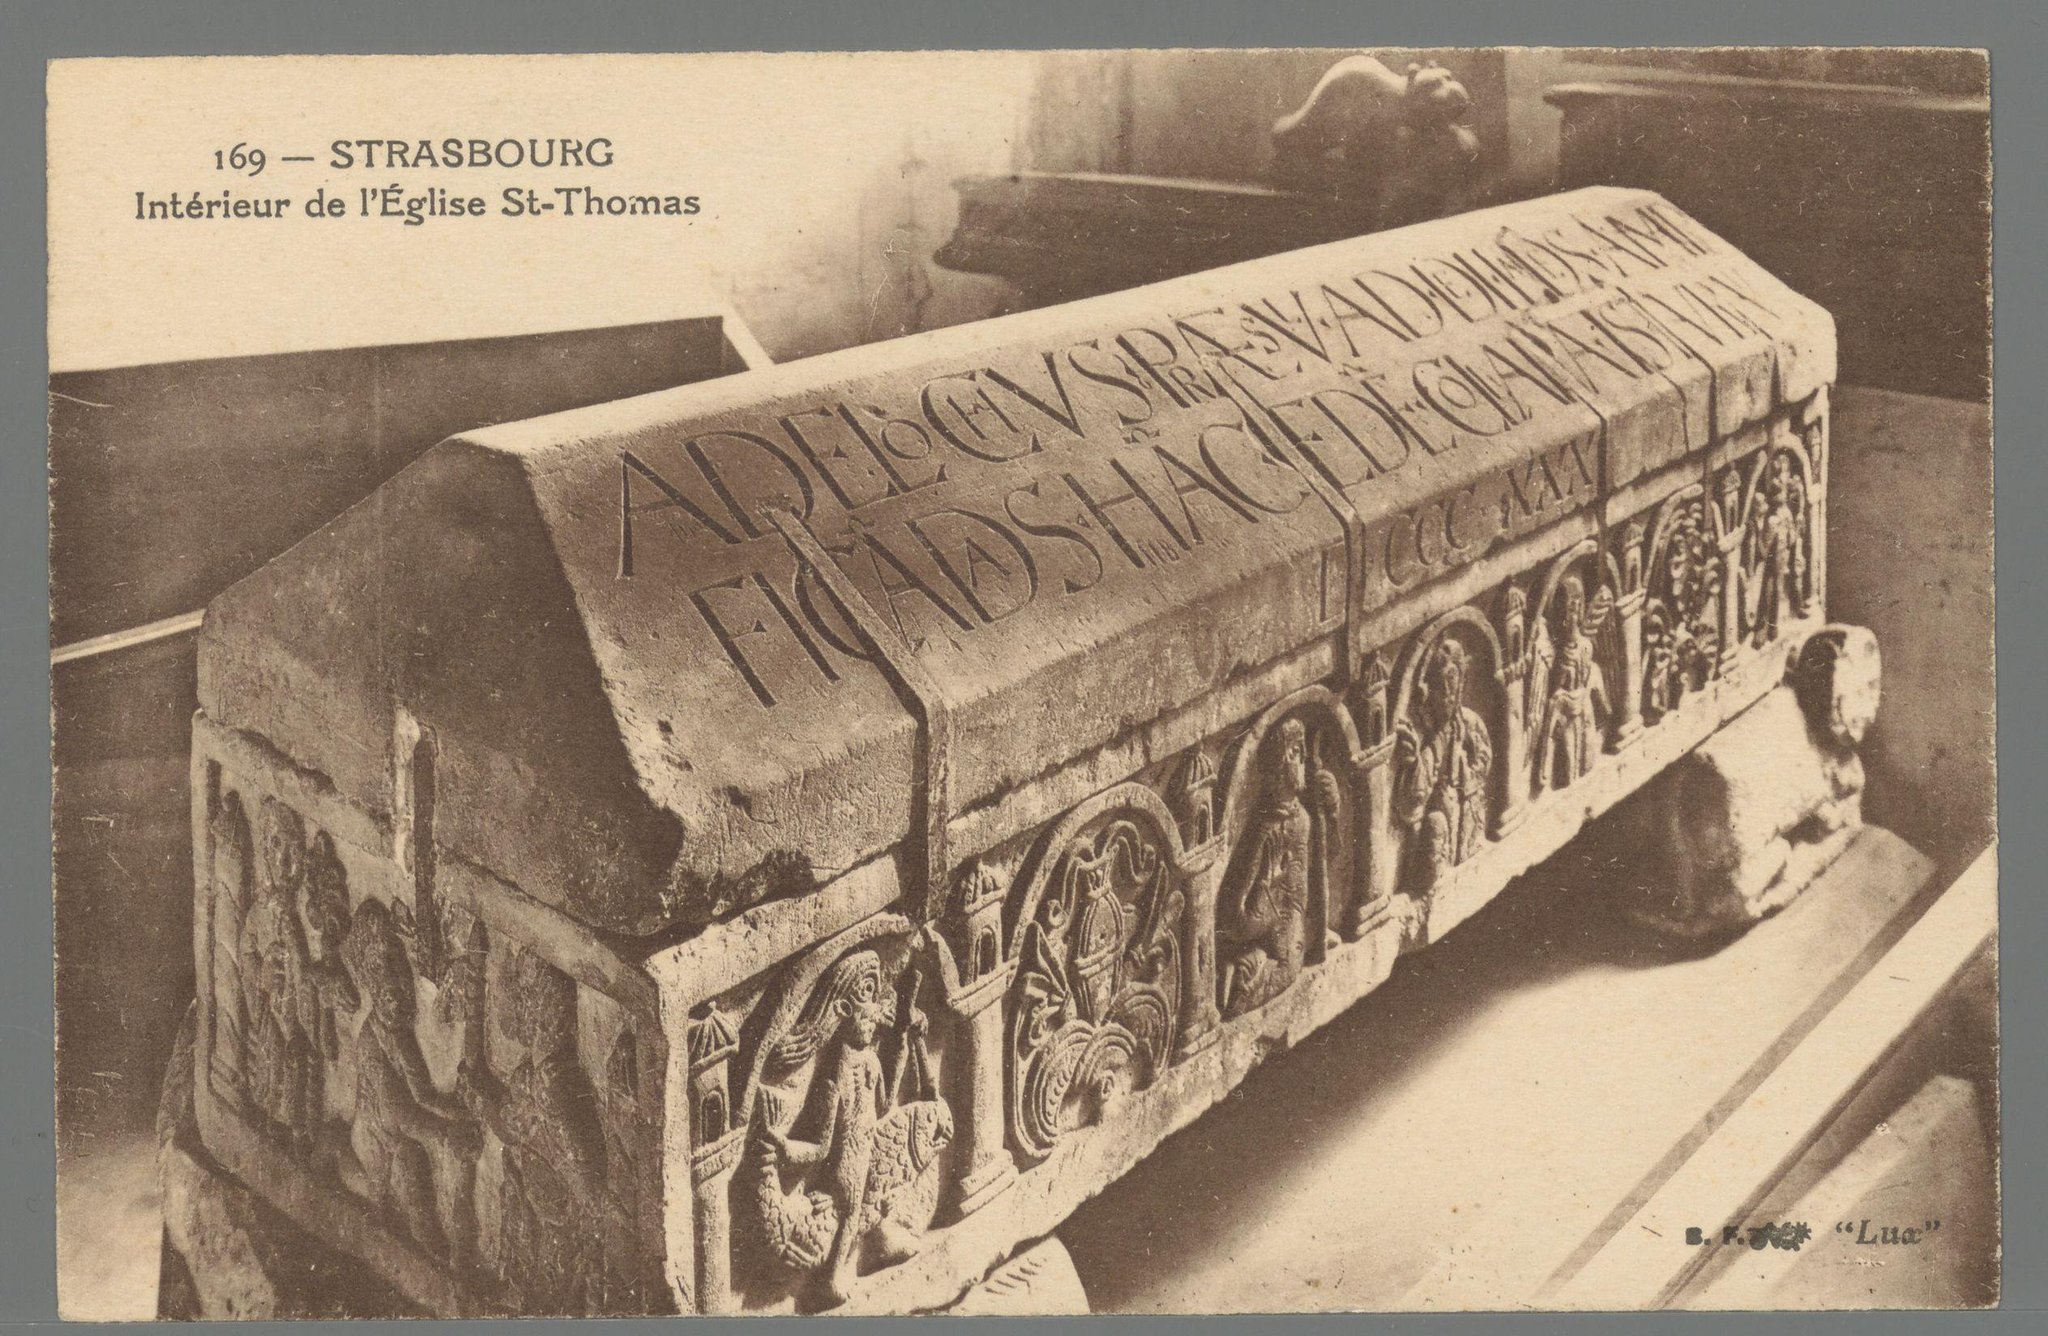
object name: photomechanical print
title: Strasbourg. Intérieur de l'Église St. Thomas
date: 1903-1908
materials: cardboard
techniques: photograph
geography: paris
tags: grave, tomb, interior of church